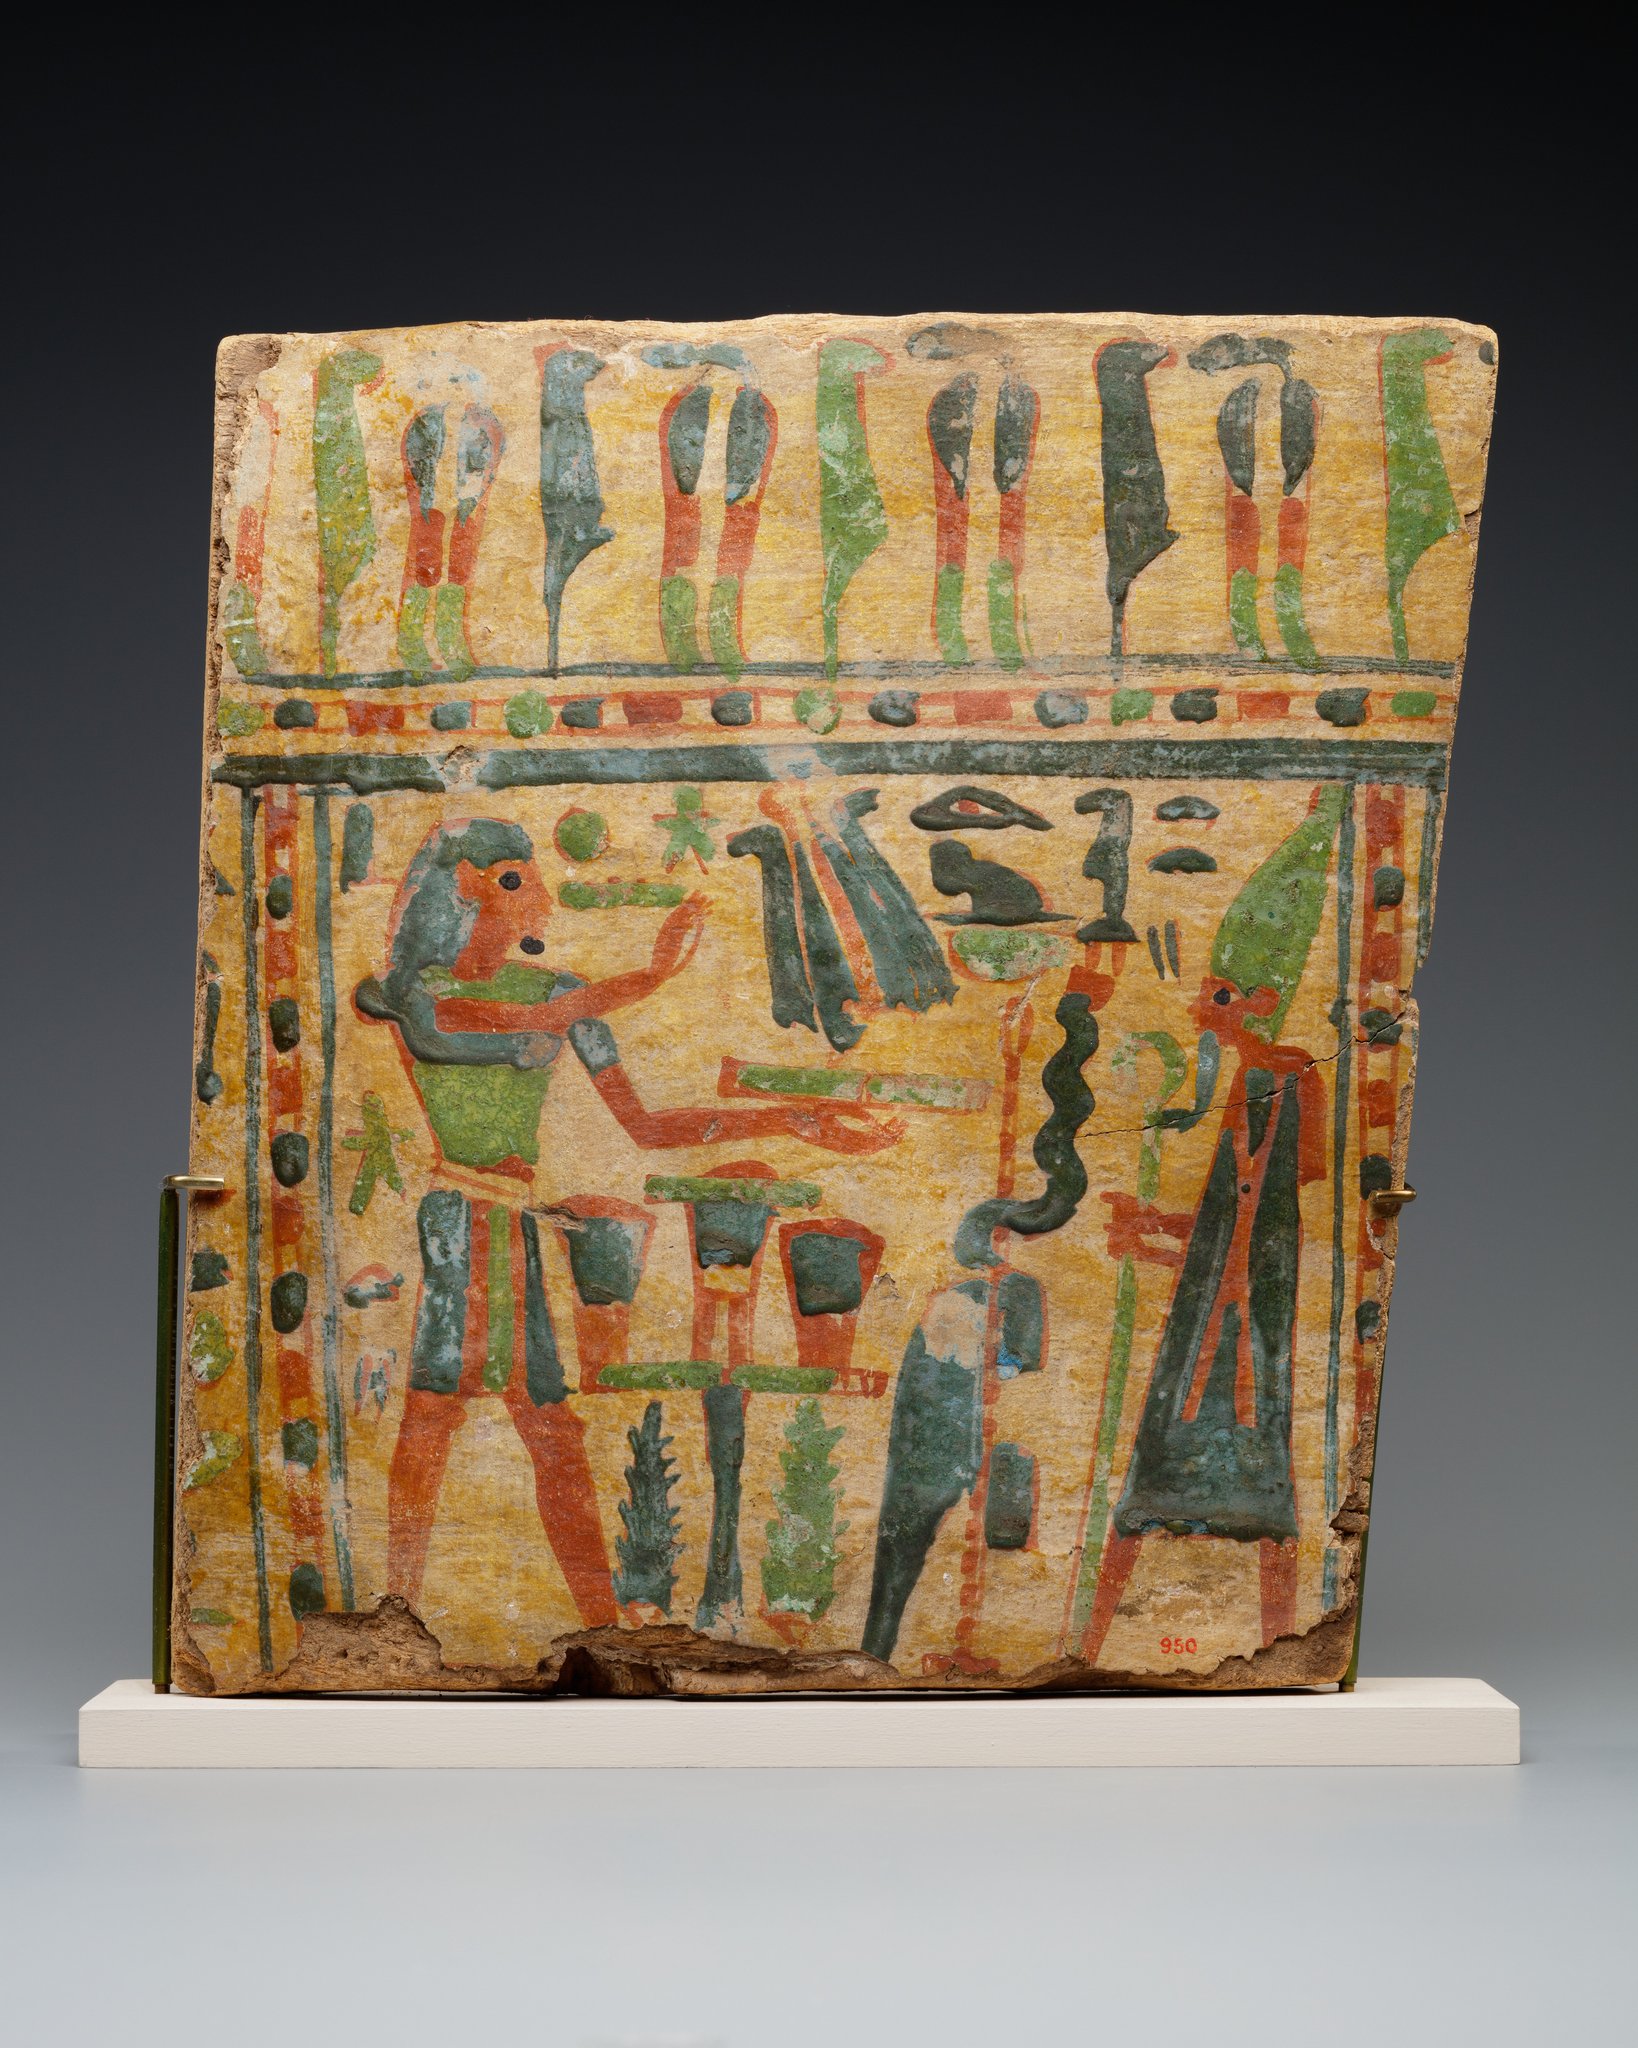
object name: coffin box part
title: Part of a coffin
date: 1070-945 BCE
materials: paint, wood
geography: egypt